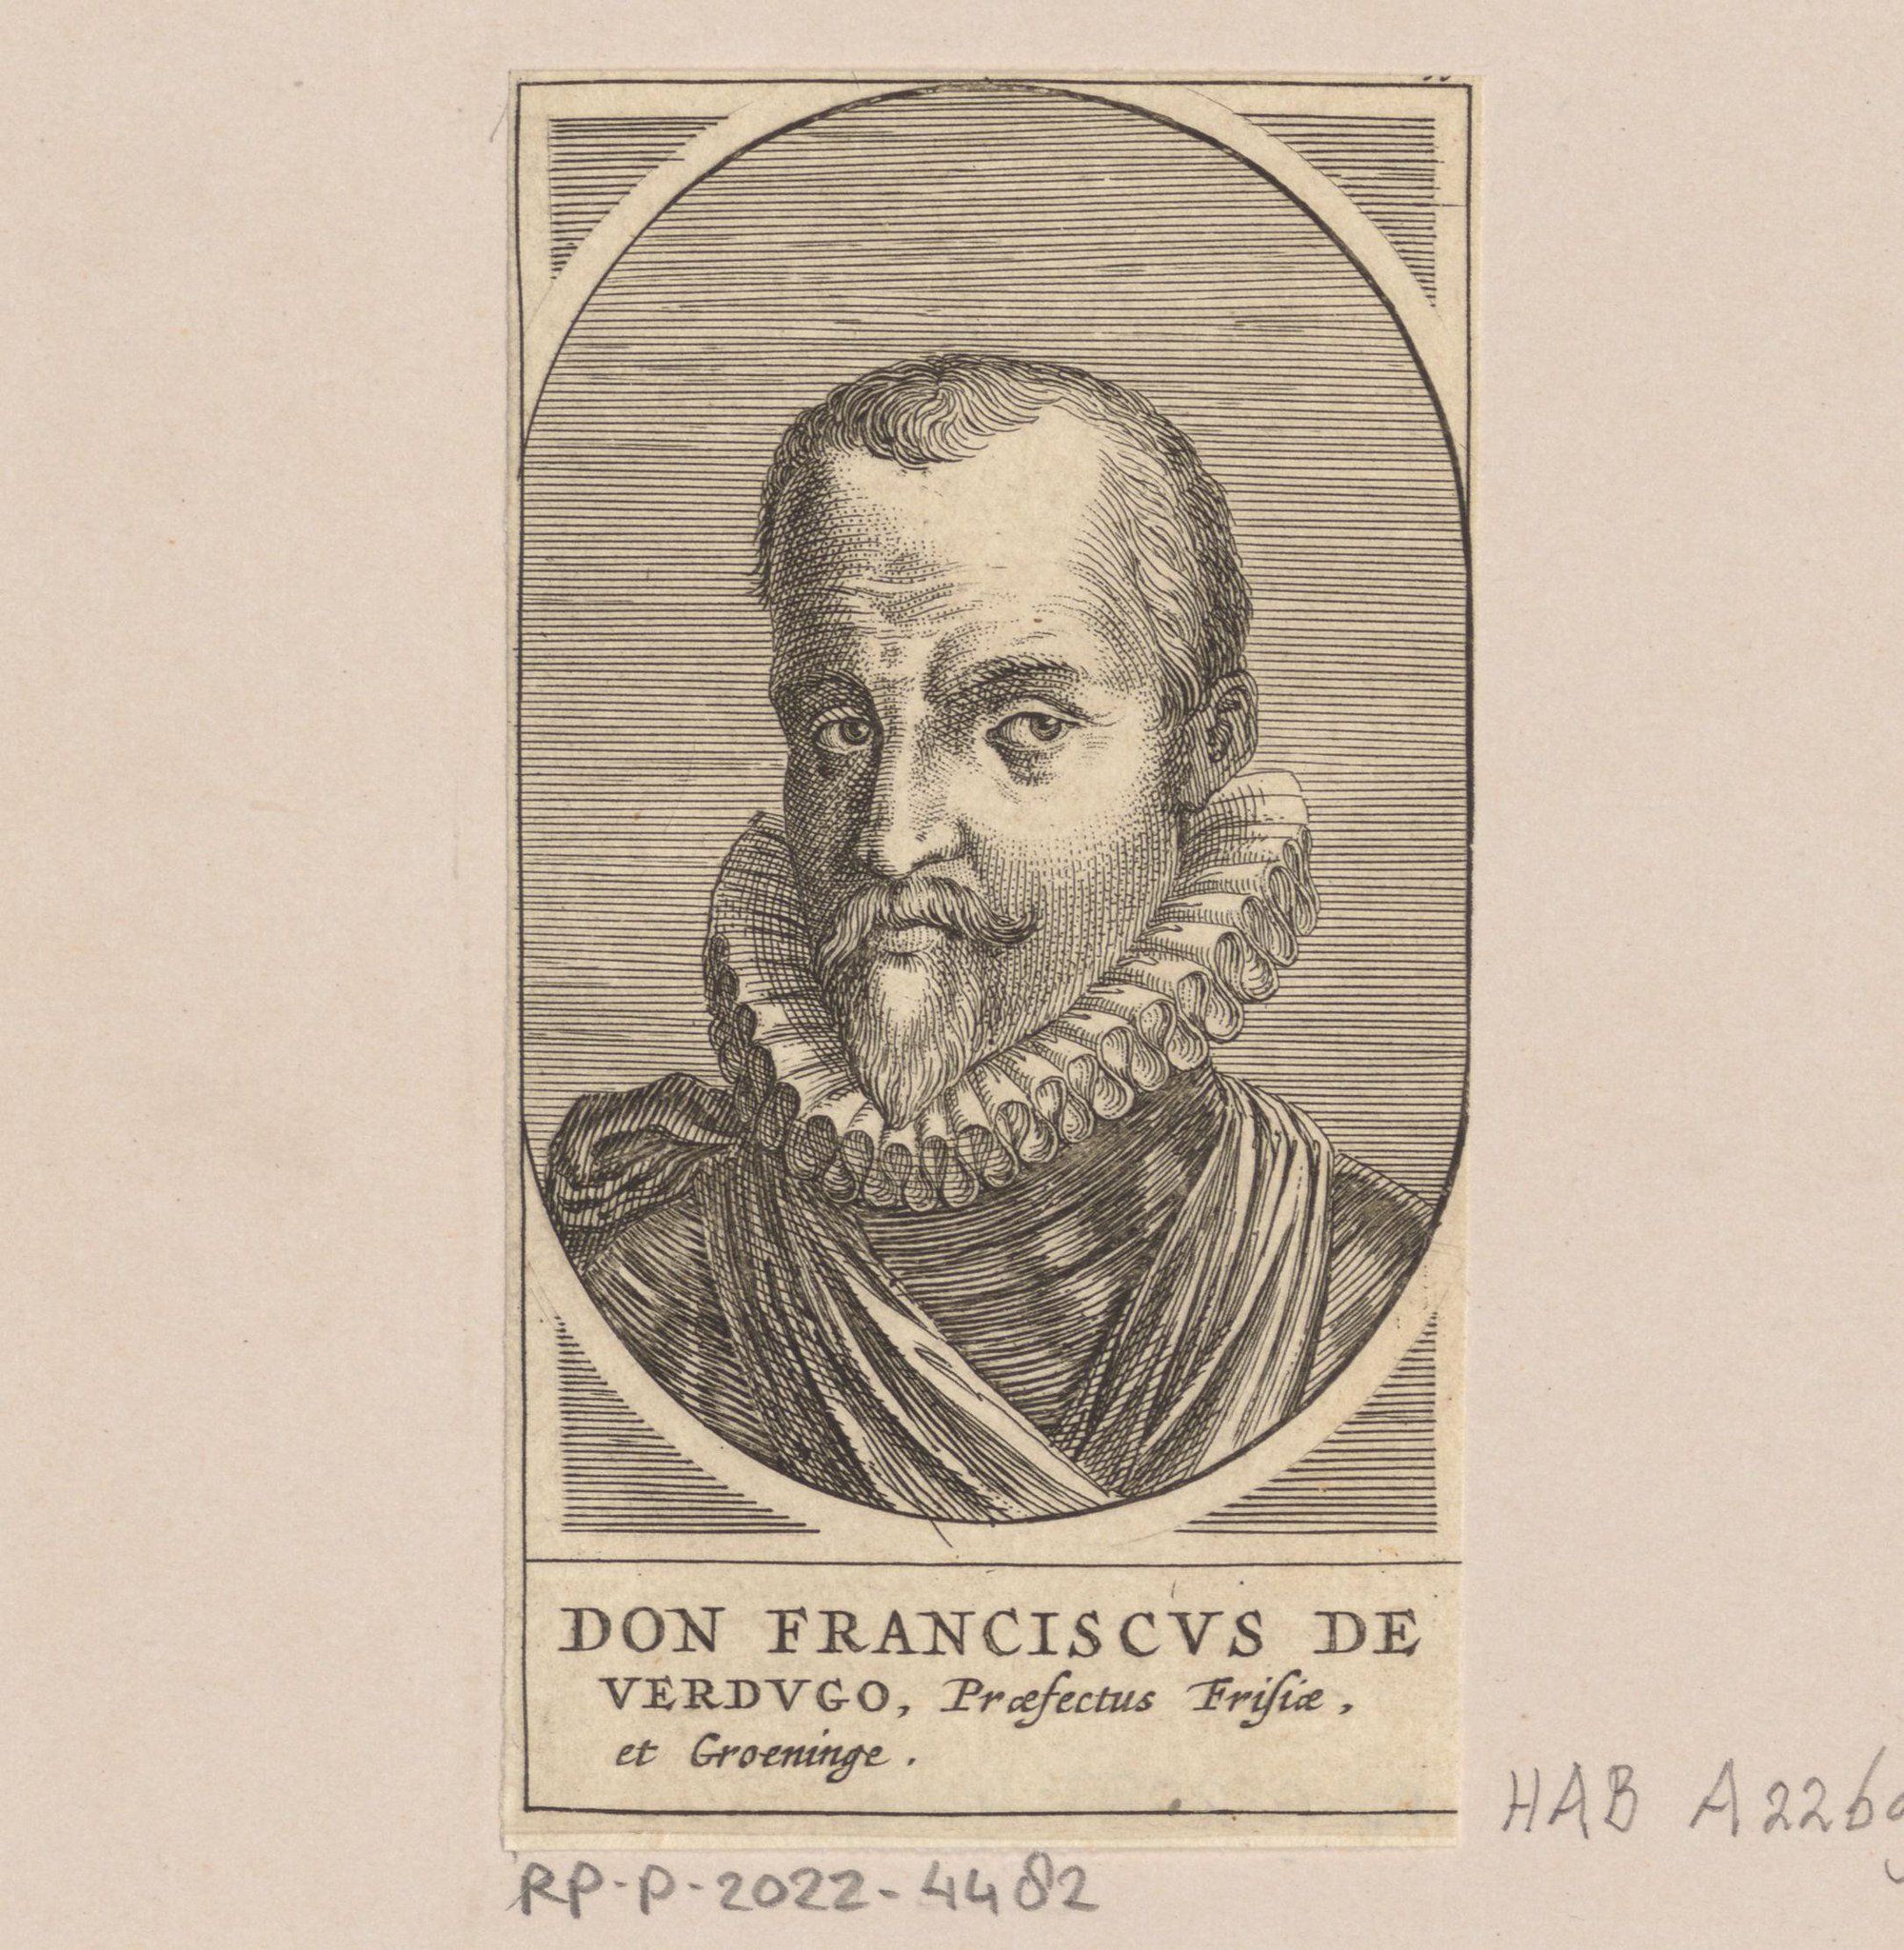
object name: print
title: Portret van Francisco Verdugo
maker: Anonymous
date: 1632-1651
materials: paper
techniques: engraving, etching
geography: italy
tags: historical persons, stadtholder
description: Prent waarschijnlijk uit een editie van: Strada, Famiano. De Bello Belgico (...). Rome: Francesco Corbelletti, 1632-1651.